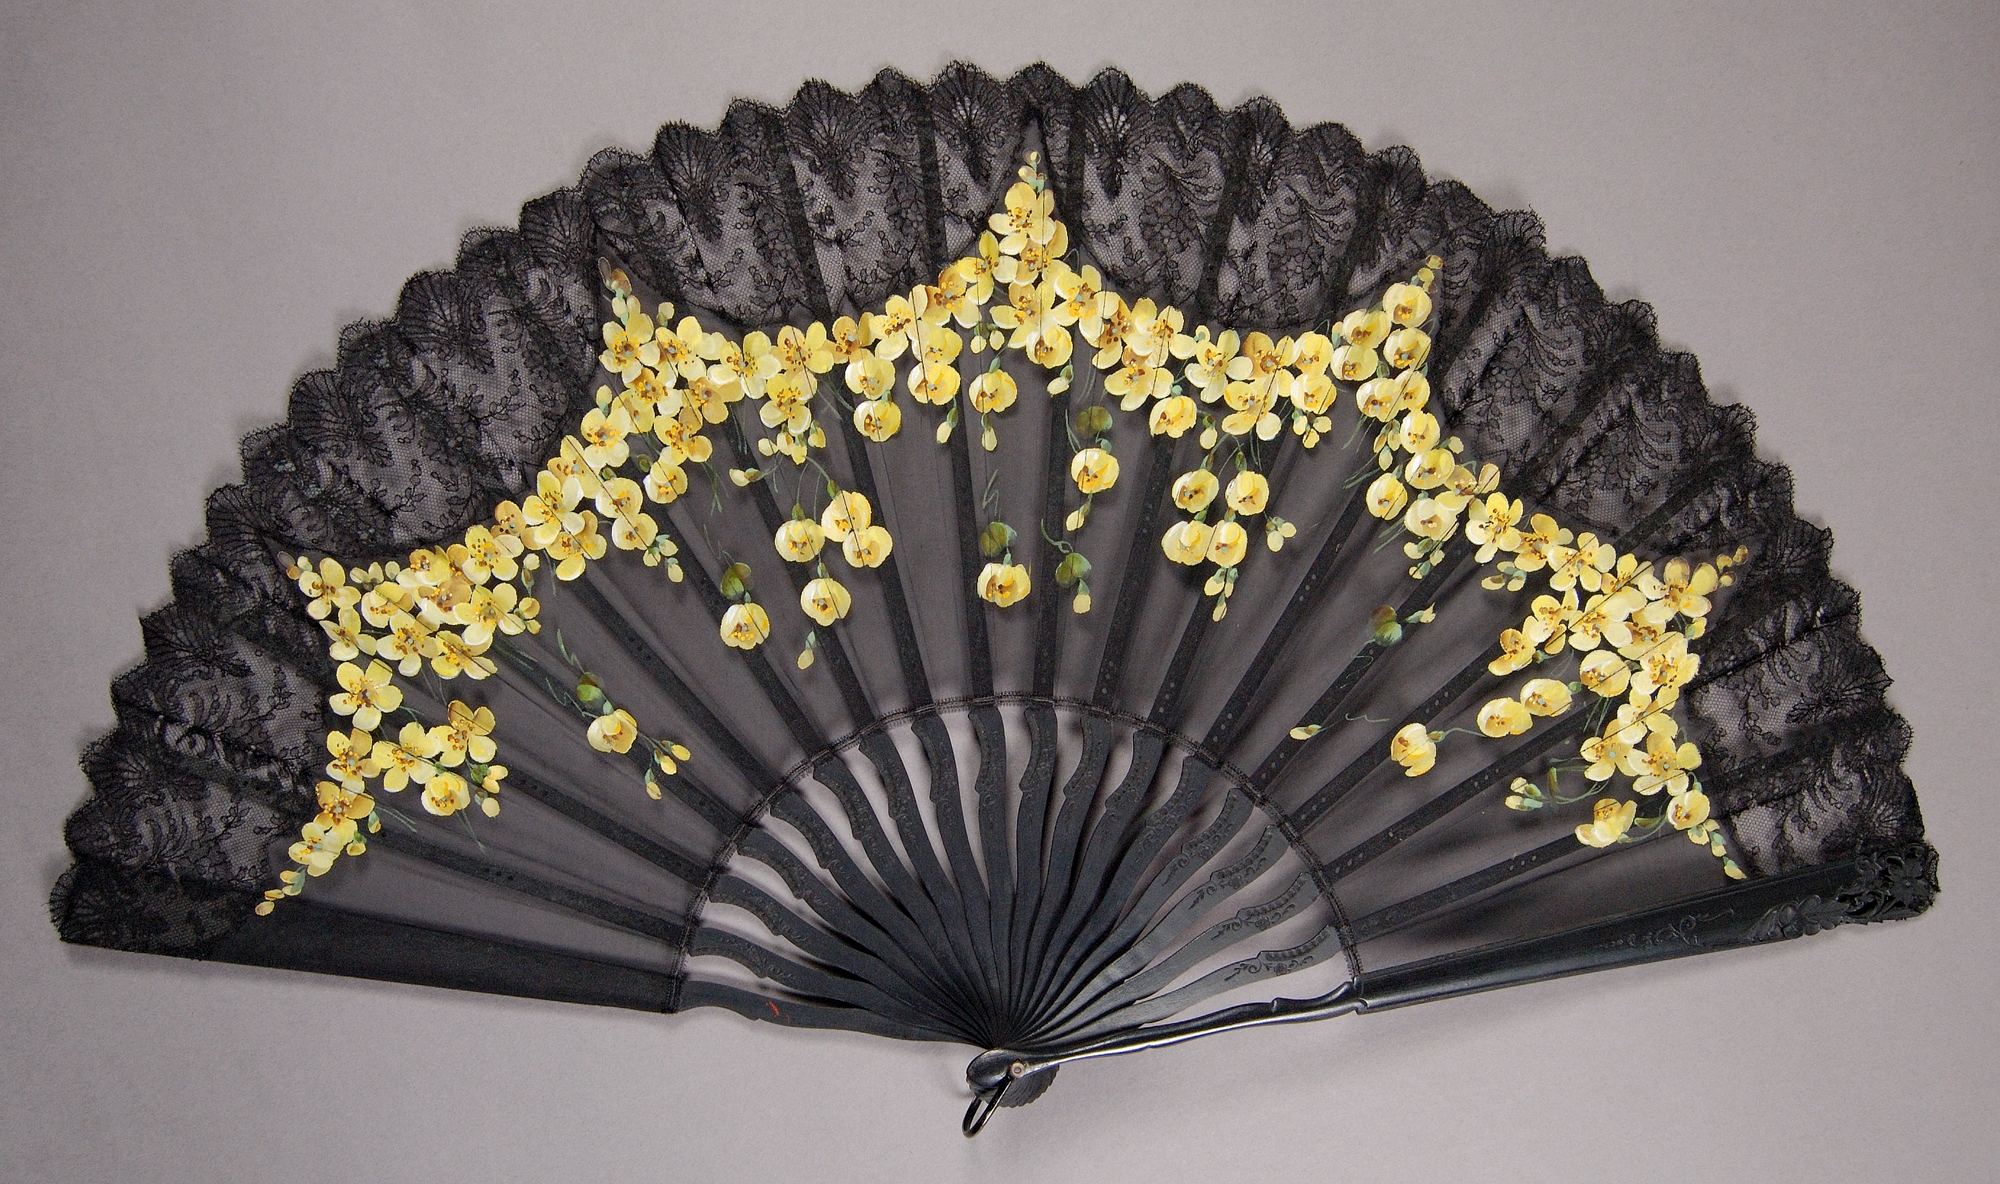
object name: fan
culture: french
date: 1885-1895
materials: metal, mother of pearl, silk, wood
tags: flowers